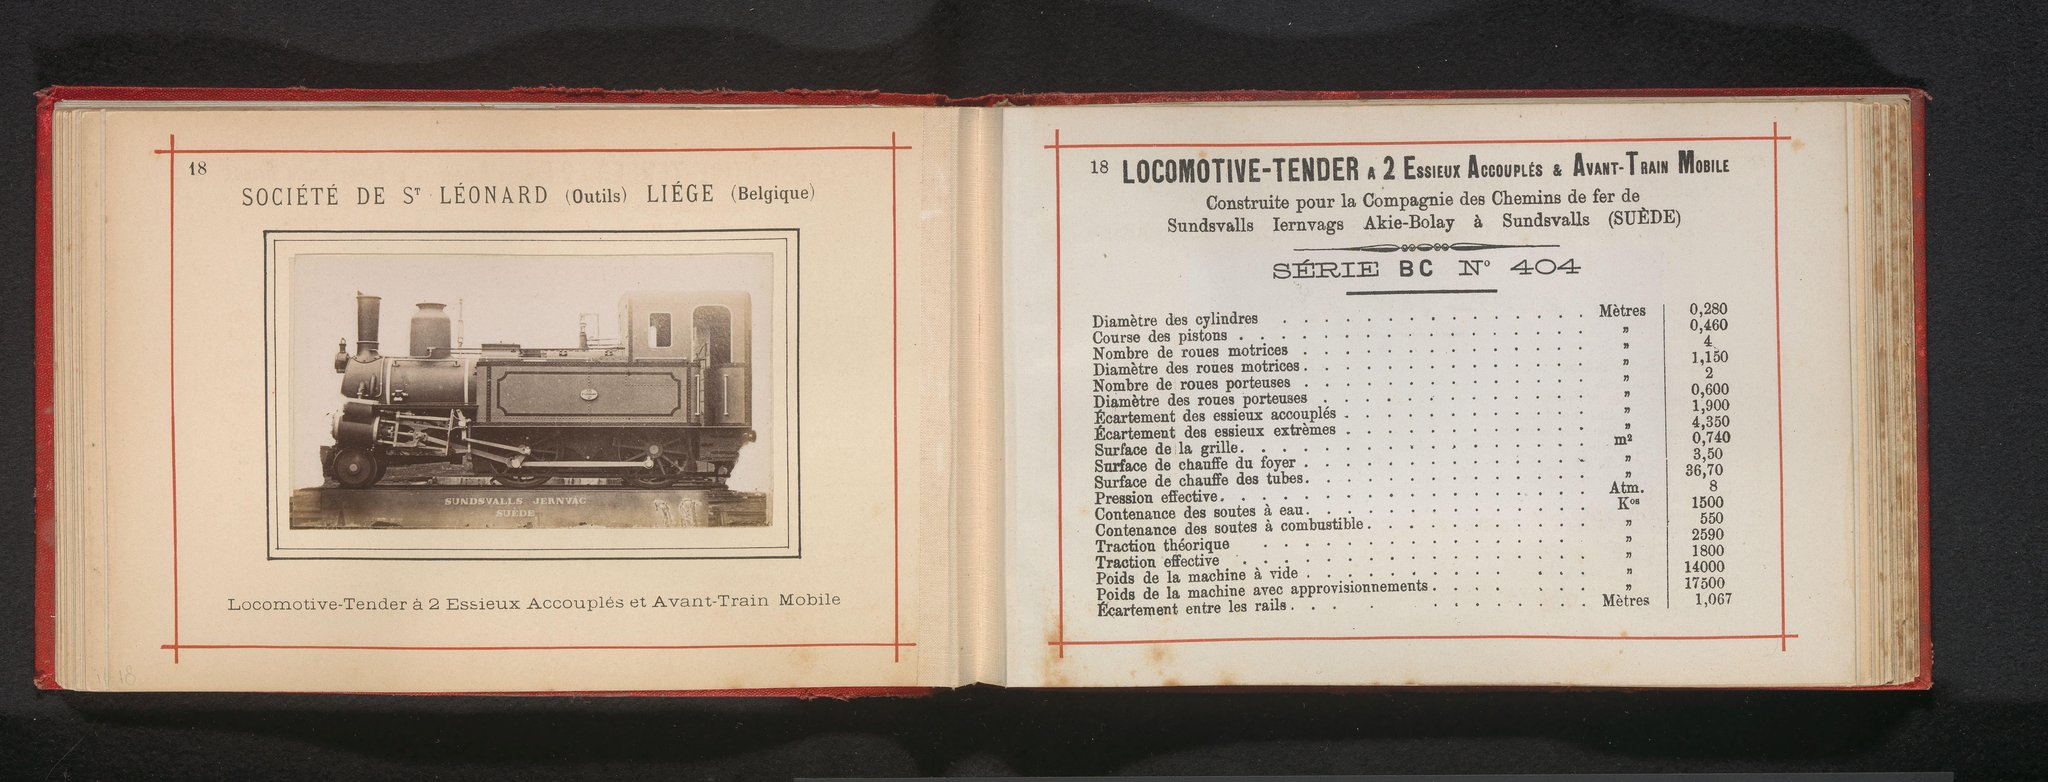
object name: page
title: Locomotive-tender a 2 essieux accouplés et avant-train mobile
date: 1880-1885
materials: photographic support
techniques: albumen print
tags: locomotive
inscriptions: inscription: ‘Société de St. Léonard (Outils) Liége (Belgique)’